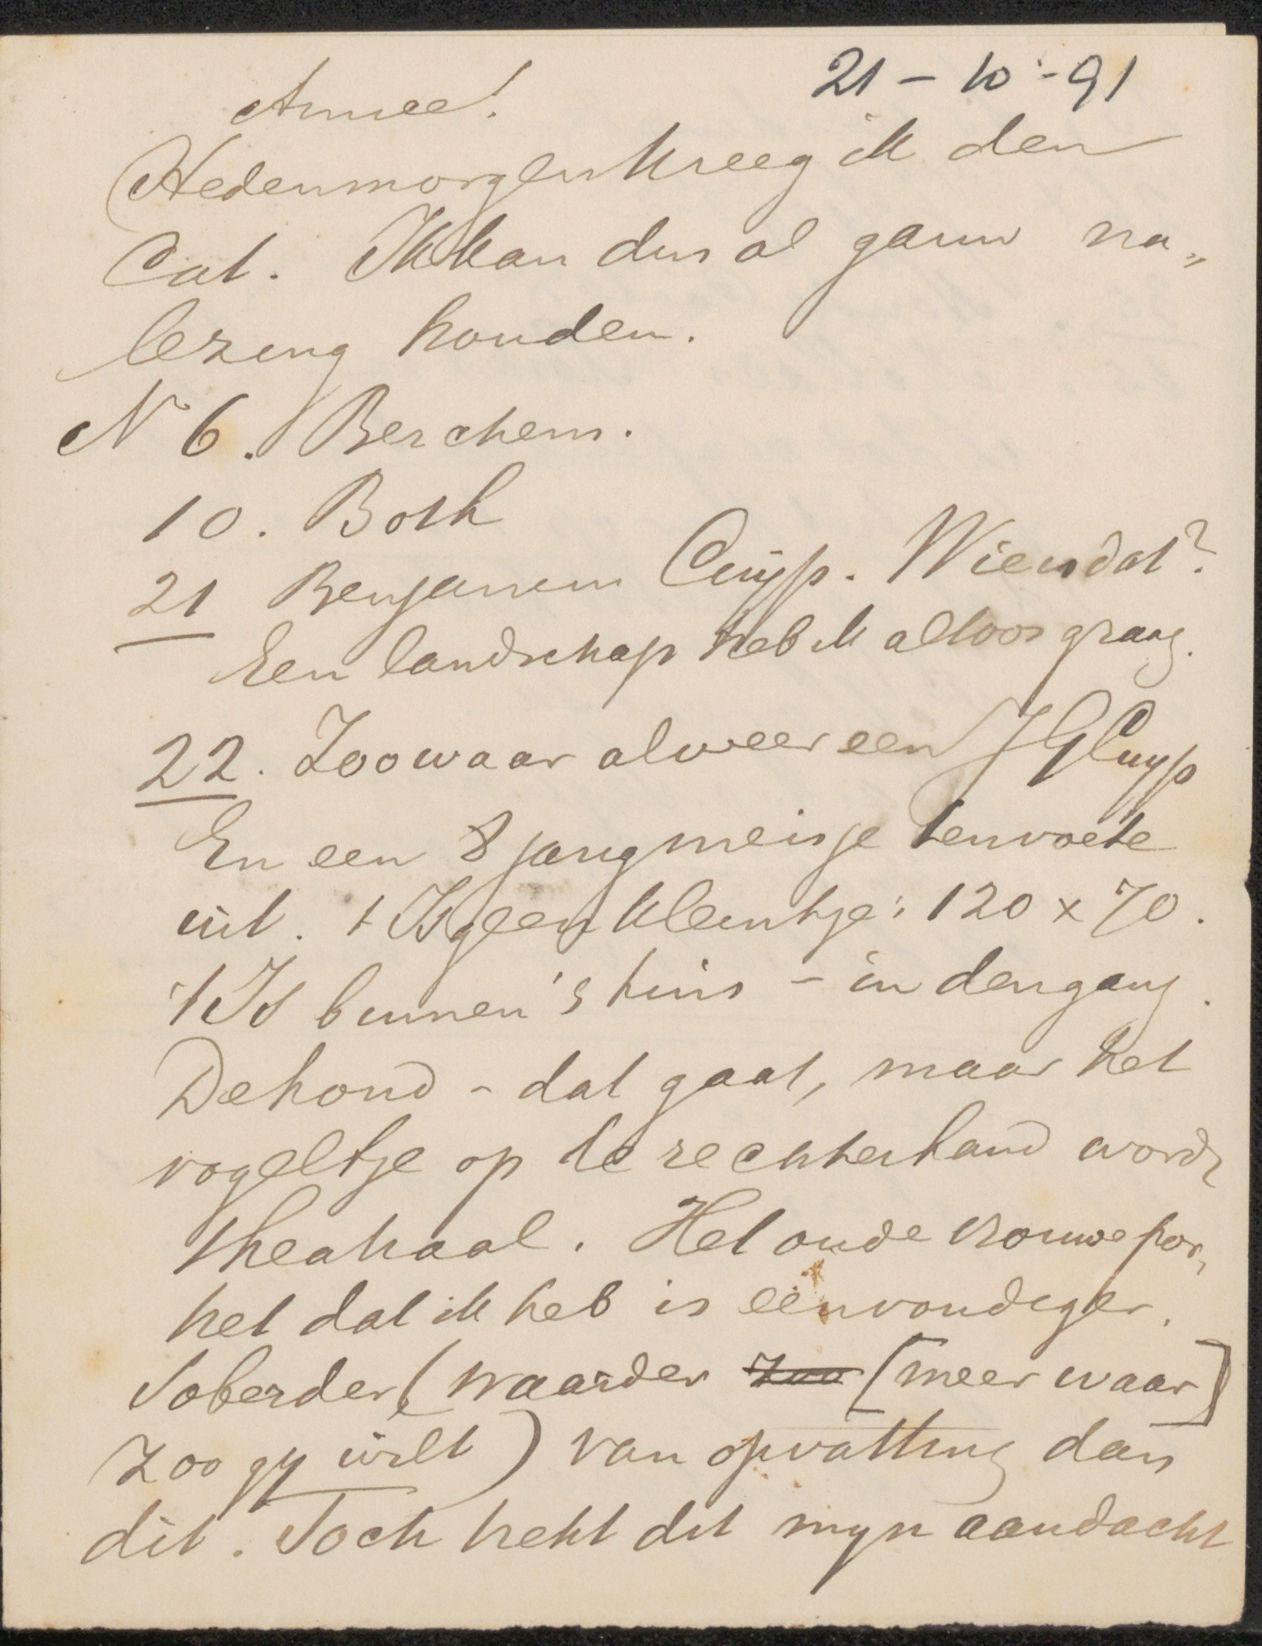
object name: letter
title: Brief aan Jan Veth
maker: martinus cornelis lebret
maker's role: verzamelaar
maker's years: 1833-1894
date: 1891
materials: ink, paper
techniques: pen, writing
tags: dordrecht, amsterdam, painter, print maker, draughtsman, designer, jan veth, art trade, art shop, the graphic arts, art collecting, printed matter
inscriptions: collector's mark: ‘RPK’